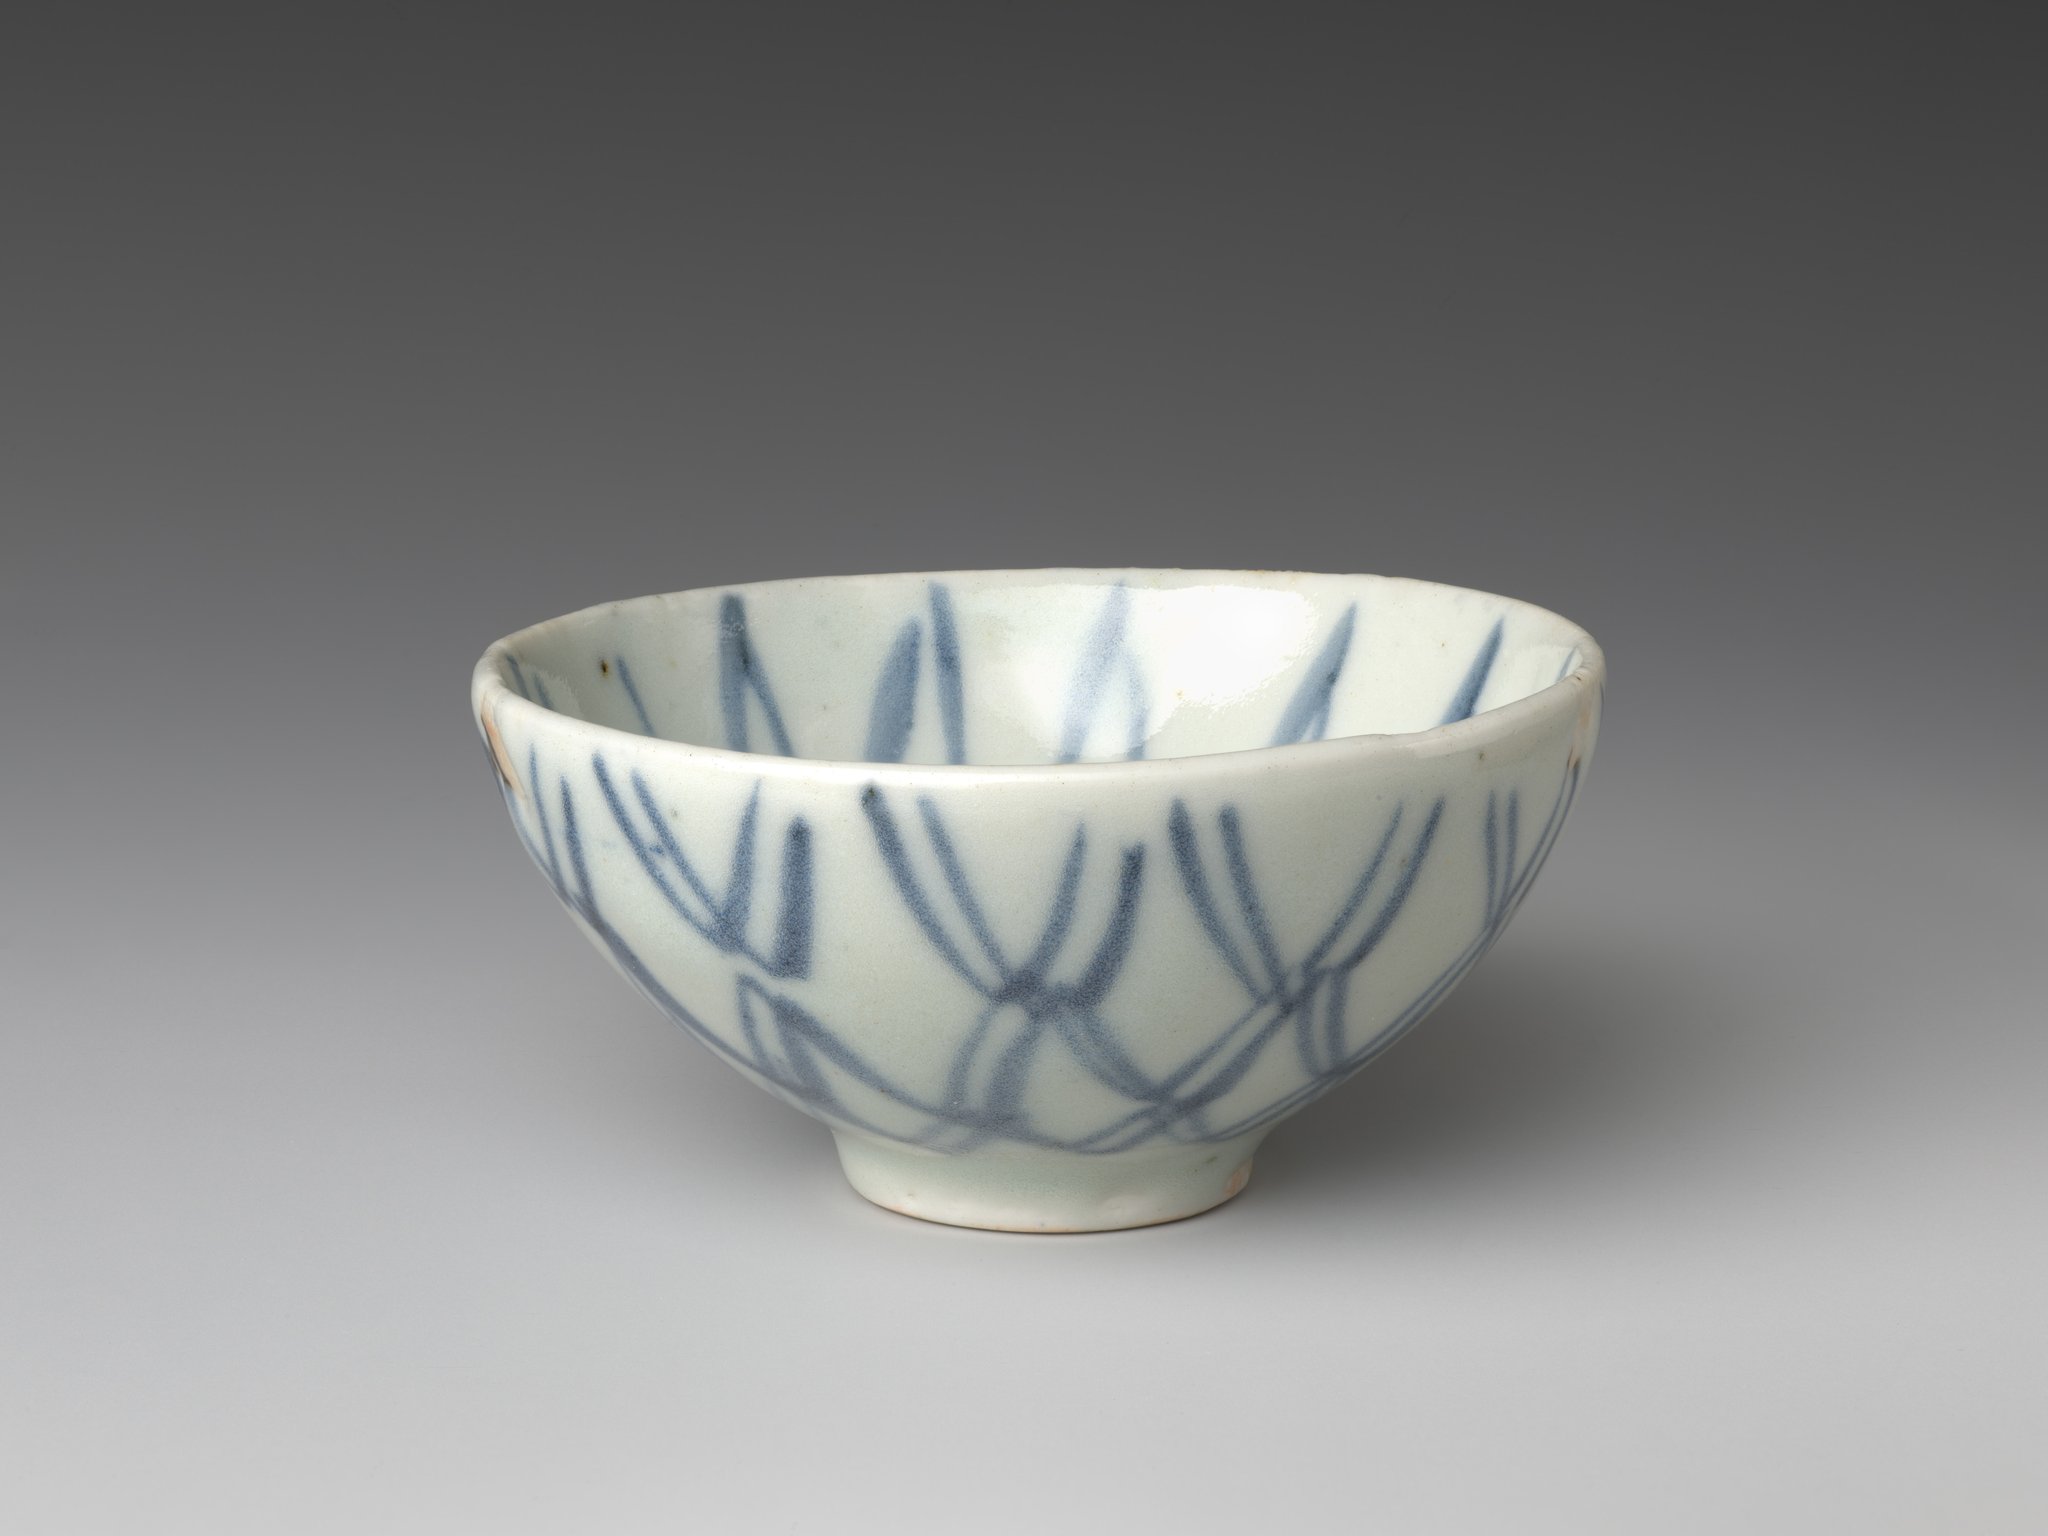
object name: wine cup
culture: japanese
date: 1701-1800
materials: porcelain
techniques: underglaze